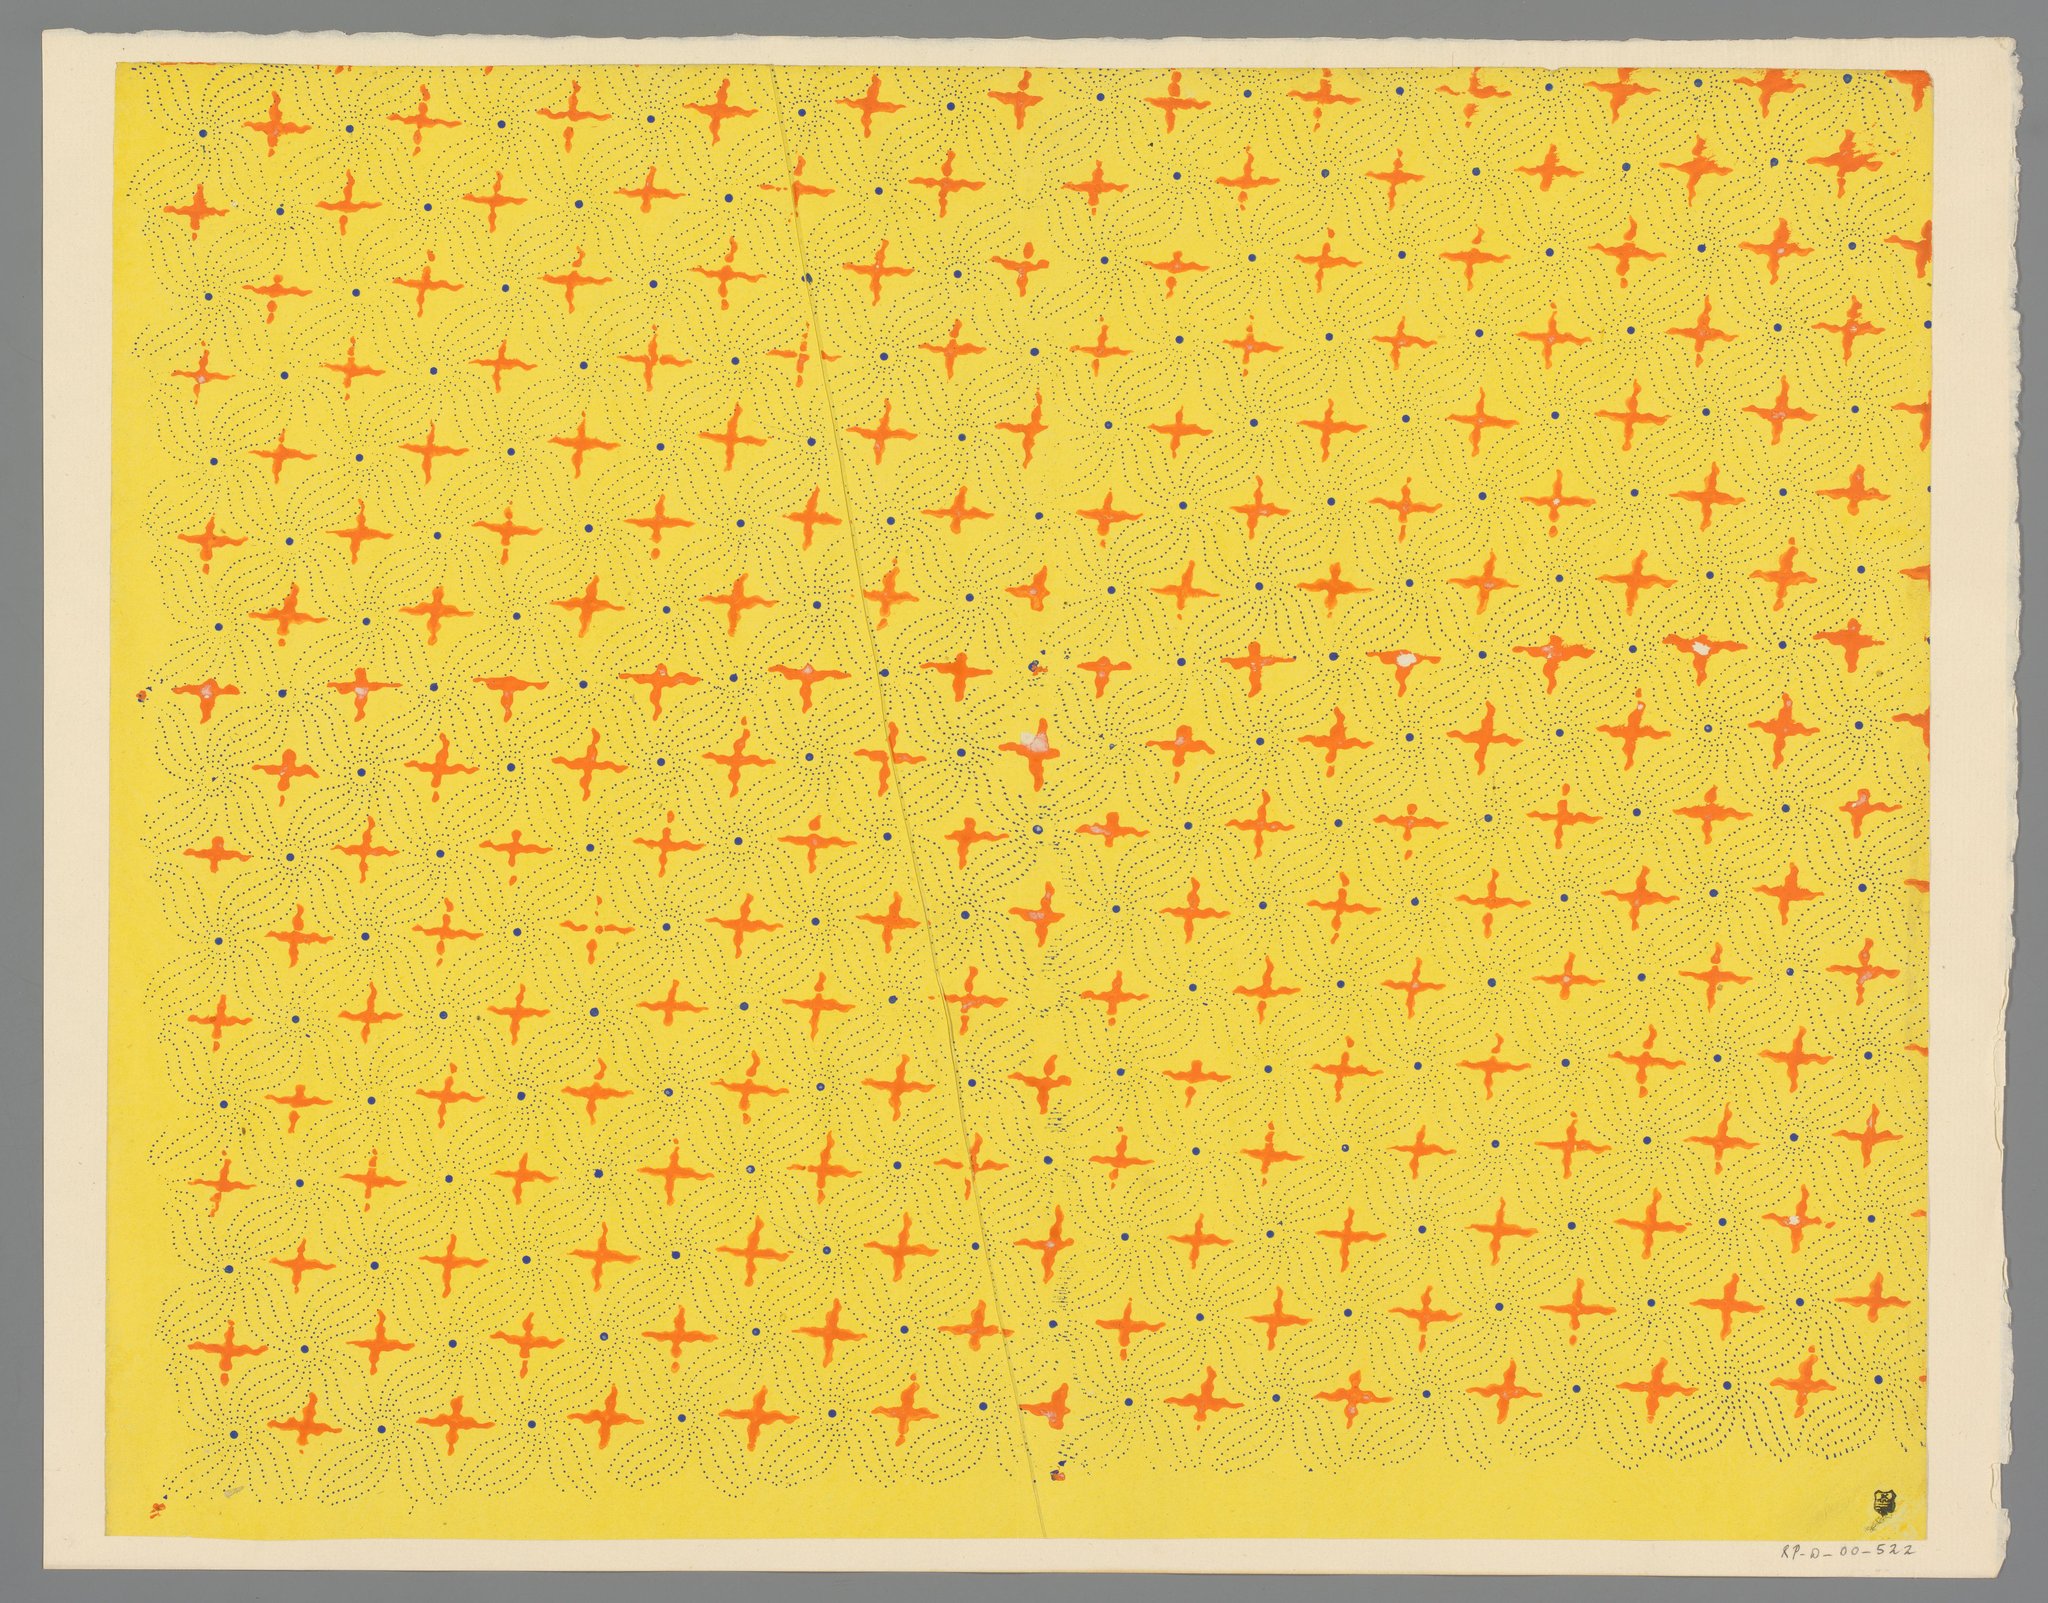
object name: printed paper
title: Blad met strooipatroon van kruismotief tussen een kruis van golvende stippellijnen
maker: Anonymous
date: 1800-1900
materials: paint, paper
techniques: printing block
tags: fantasy ornament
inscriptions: collector's mark: Lugt 2760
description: Blad met strooipatroon van kruismotief tussen een kruis van golvende stippellijnen.